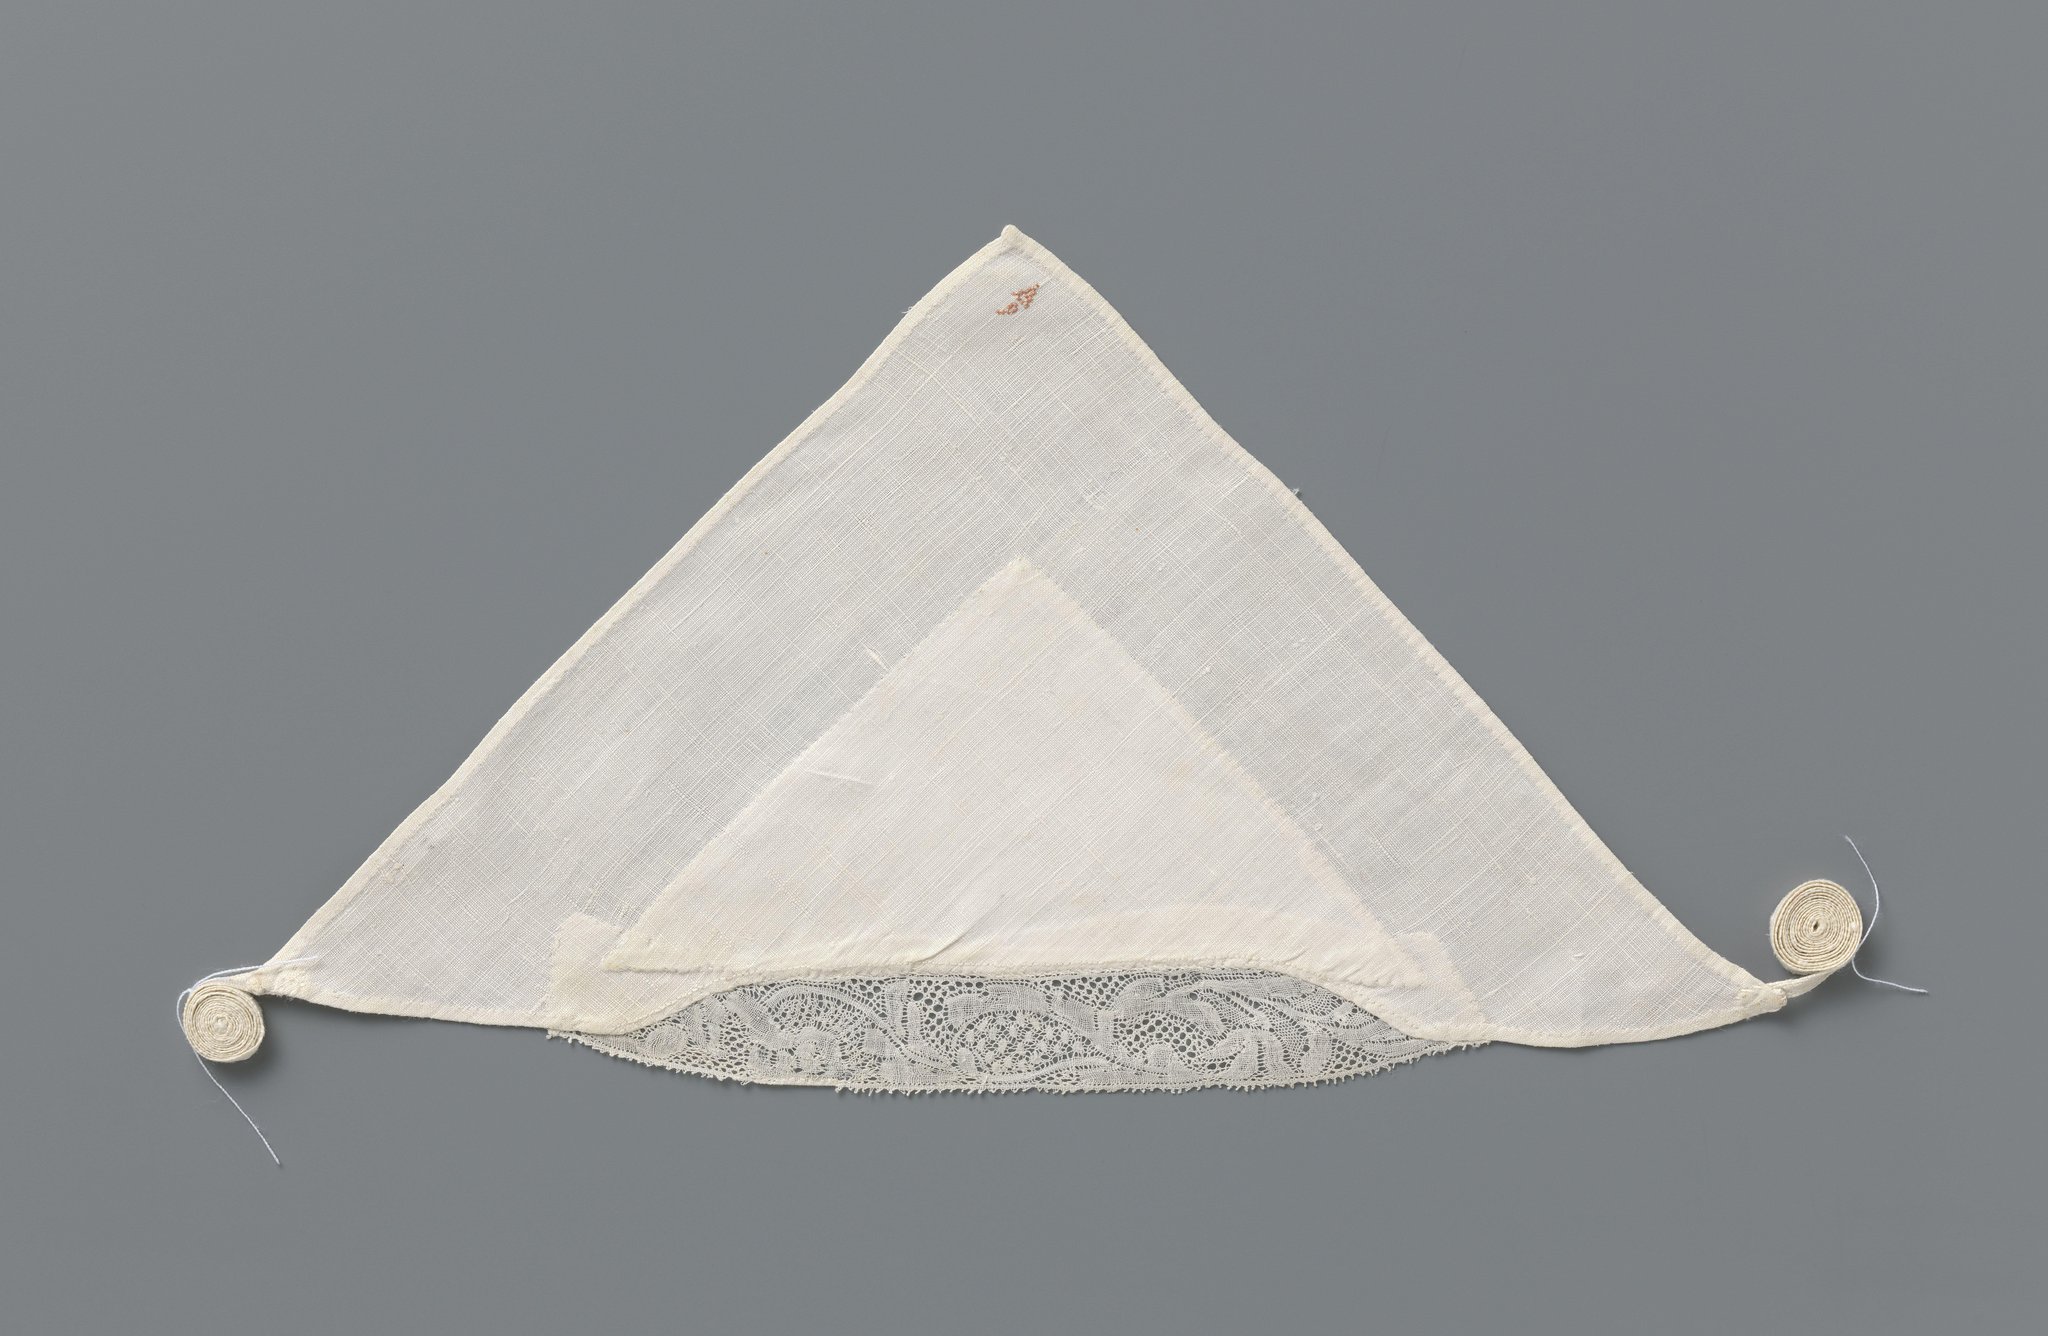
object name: childrenswear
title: Fontaneldoek van linnen met strook Binchekant, met een rechte rand met dubbele bladrank die een cartouche met spinnetjes vormt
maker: Anonymous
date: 1700-1800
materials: linen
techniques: lace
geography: europe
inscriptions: inscription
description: Fontaneldoekje van linnen met een strook kloskant type Binche. Rechte rand met dubbele bladrank die een cartouche met spinnetjes vormt.